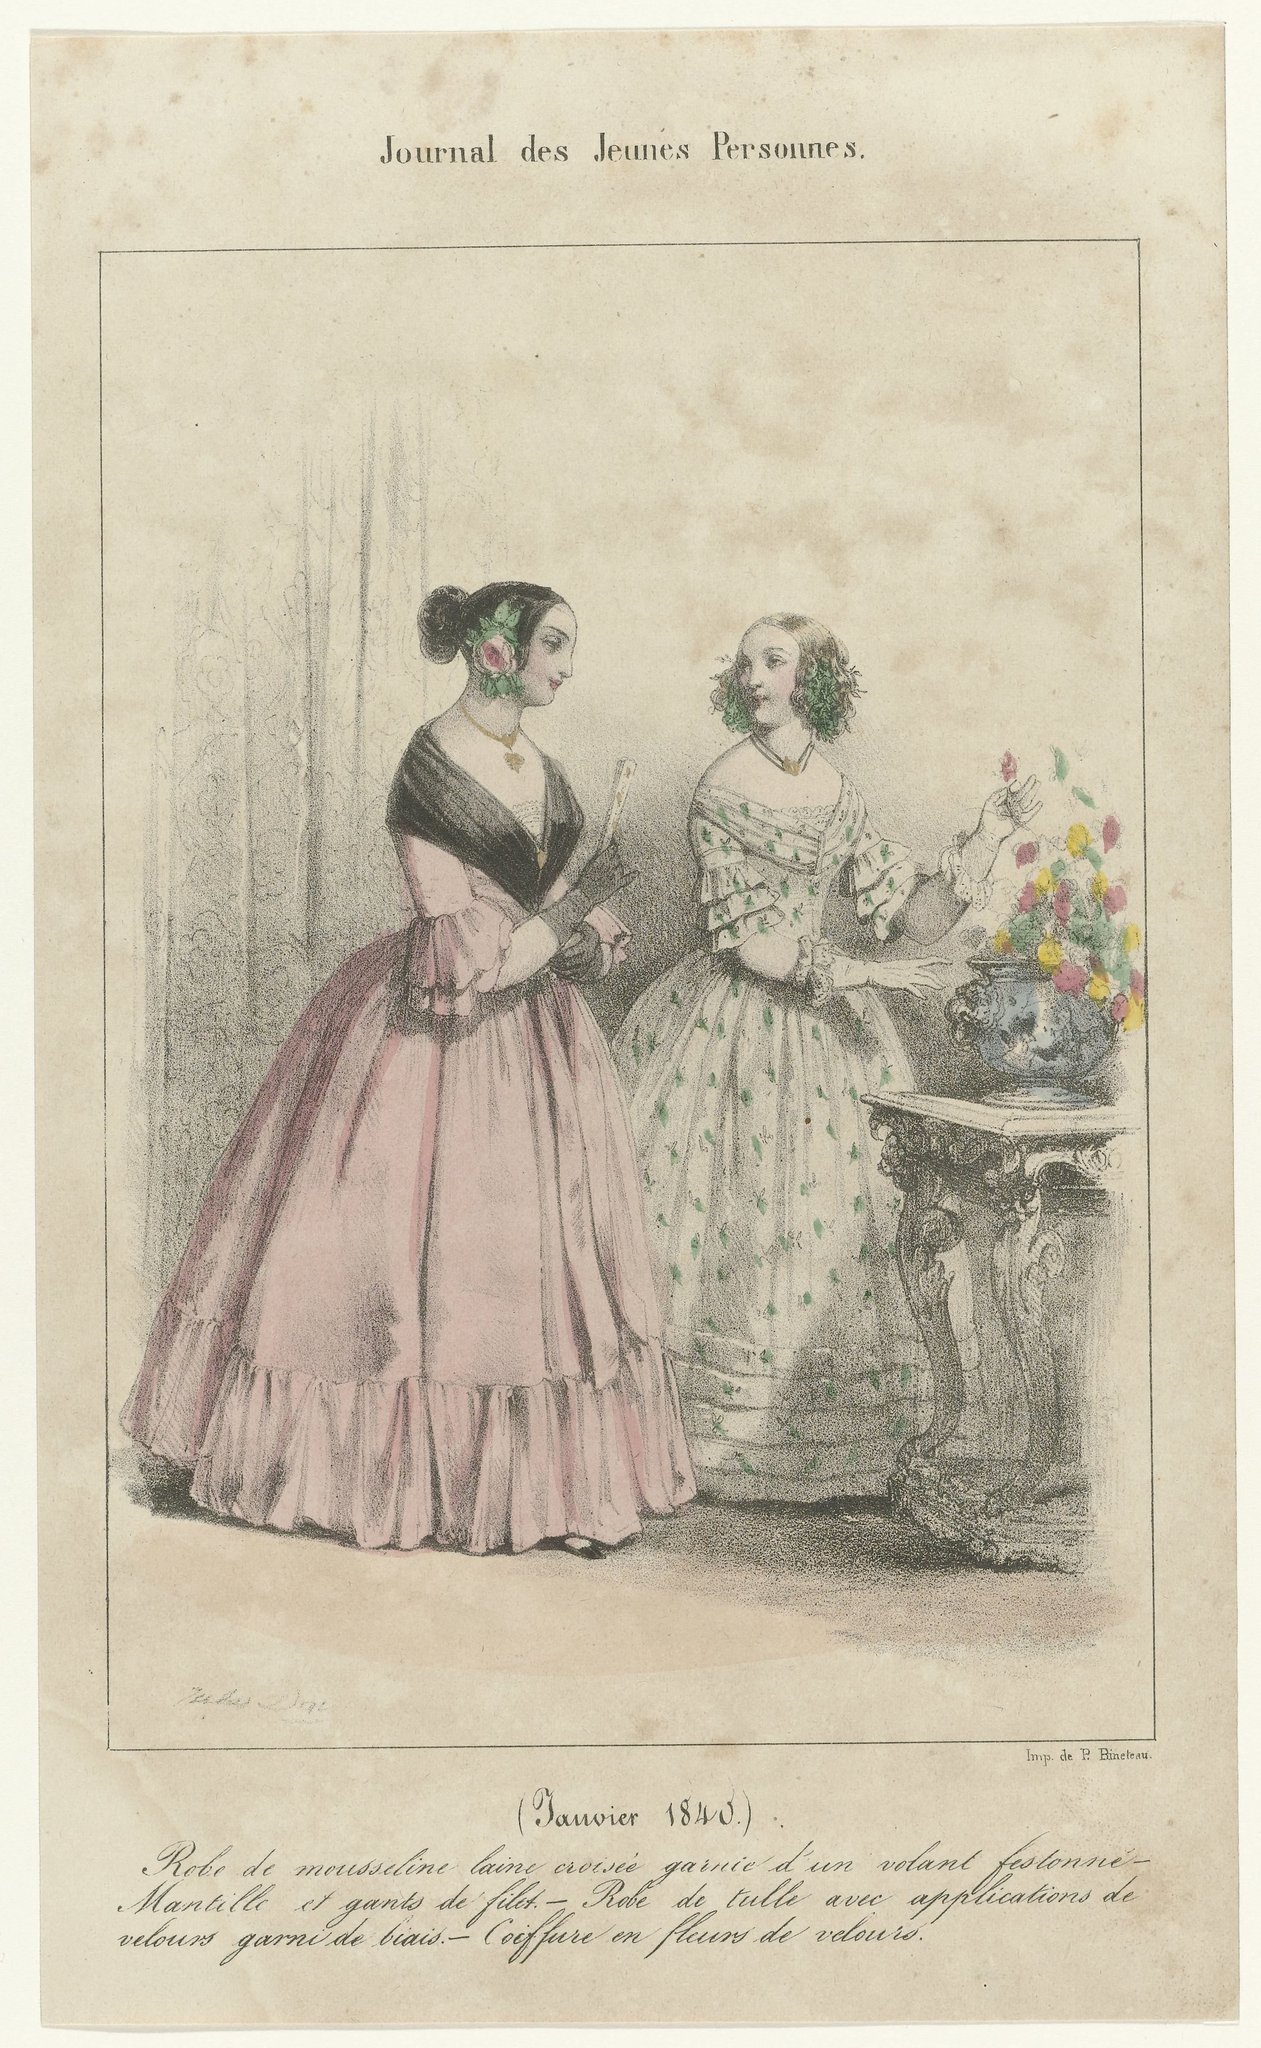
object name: fashion print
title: Journal des Jeunes Personnes, janvier 1840 : Robe de mousselin (...)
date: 1840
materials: paper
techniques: hand coloring, lithograph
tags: flowers, arranging flowers, clothing for the upper part of the body (mantelet) (+ women's clothes), styles of hairdress - aa - ~ women, fashion plates, gloves, mittens, etc. (+ women's clothes), dress, gown (+ women's clothes), necklace (+ women's clothes)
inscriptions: caption: ‘Robe de mousseline laine croisée garnie d'un volant festonné-Mantille et gants de filet-Robe de tulle avec applications de velours garni de biais- Coeffure en fleurs de velours.’, title: ‘Journal des Jeunes Personnes’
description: Twee vrouwen bij een vaas met bloemen. Volgens het onderschrift: japon van wollen mousseline versierd met een volant met geschulpte zoom. 'Mantille' en handschoenen van filet. Rechts: japon van tule met fluwelen applicaties en versierd met biaisband. 'Coeffure' met bloemen van fluweel. Prent uit het modetijdschrift Journal des Jeunes Personnes (1833-1868 en 1892-1898).